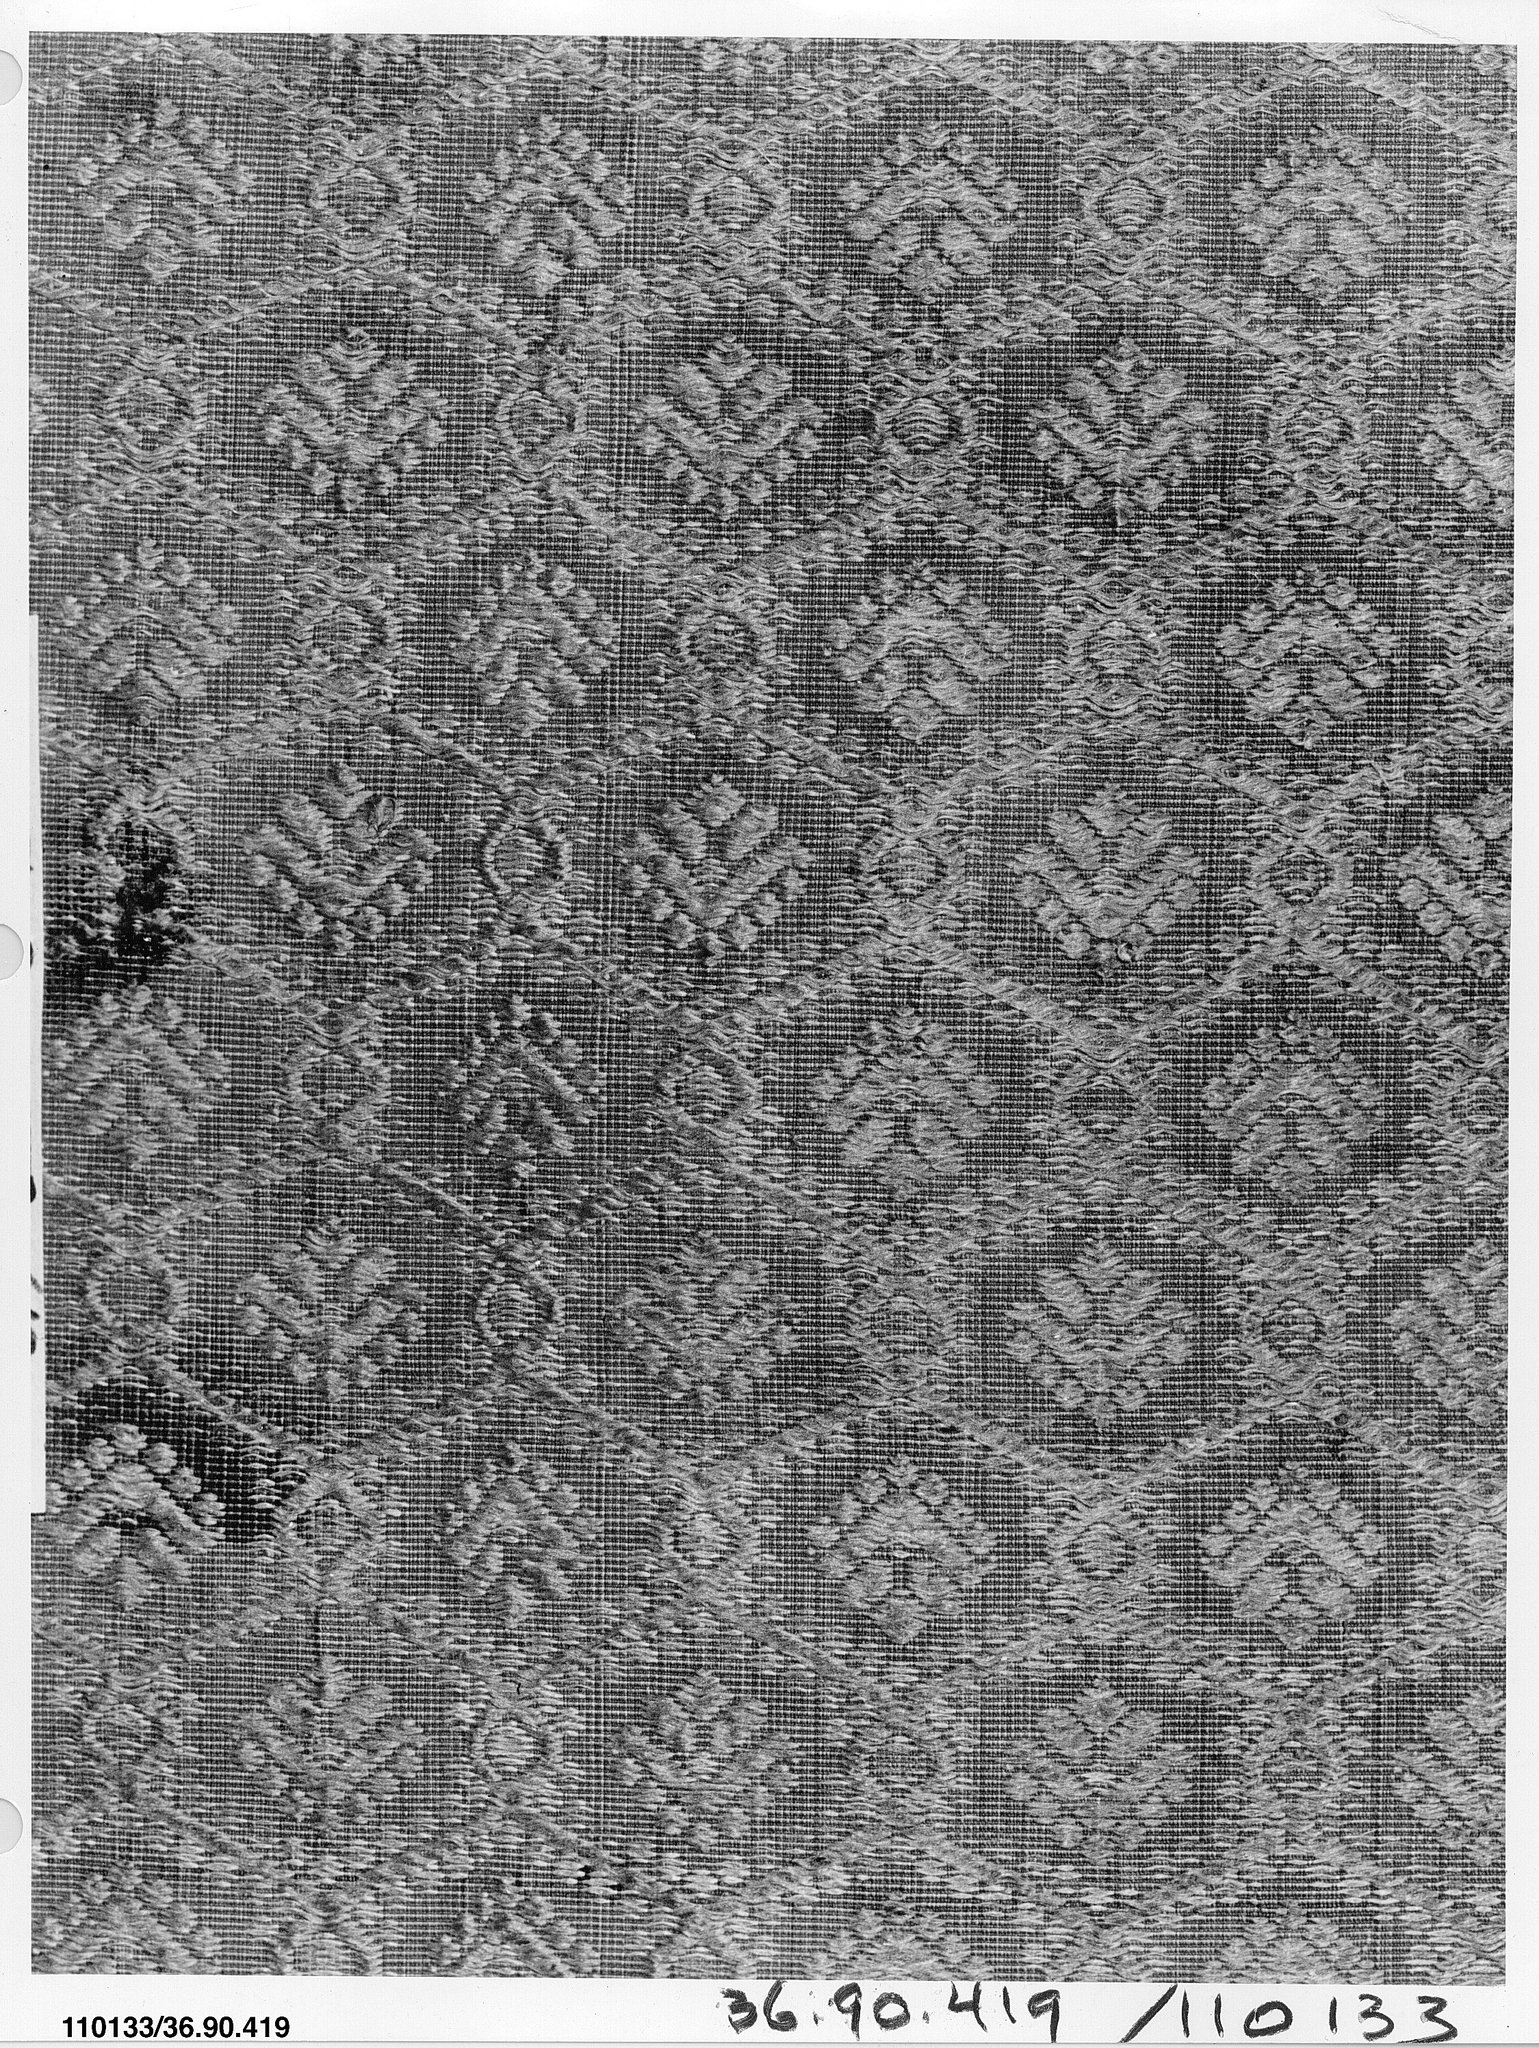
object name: piece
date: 1501-1700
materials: silk